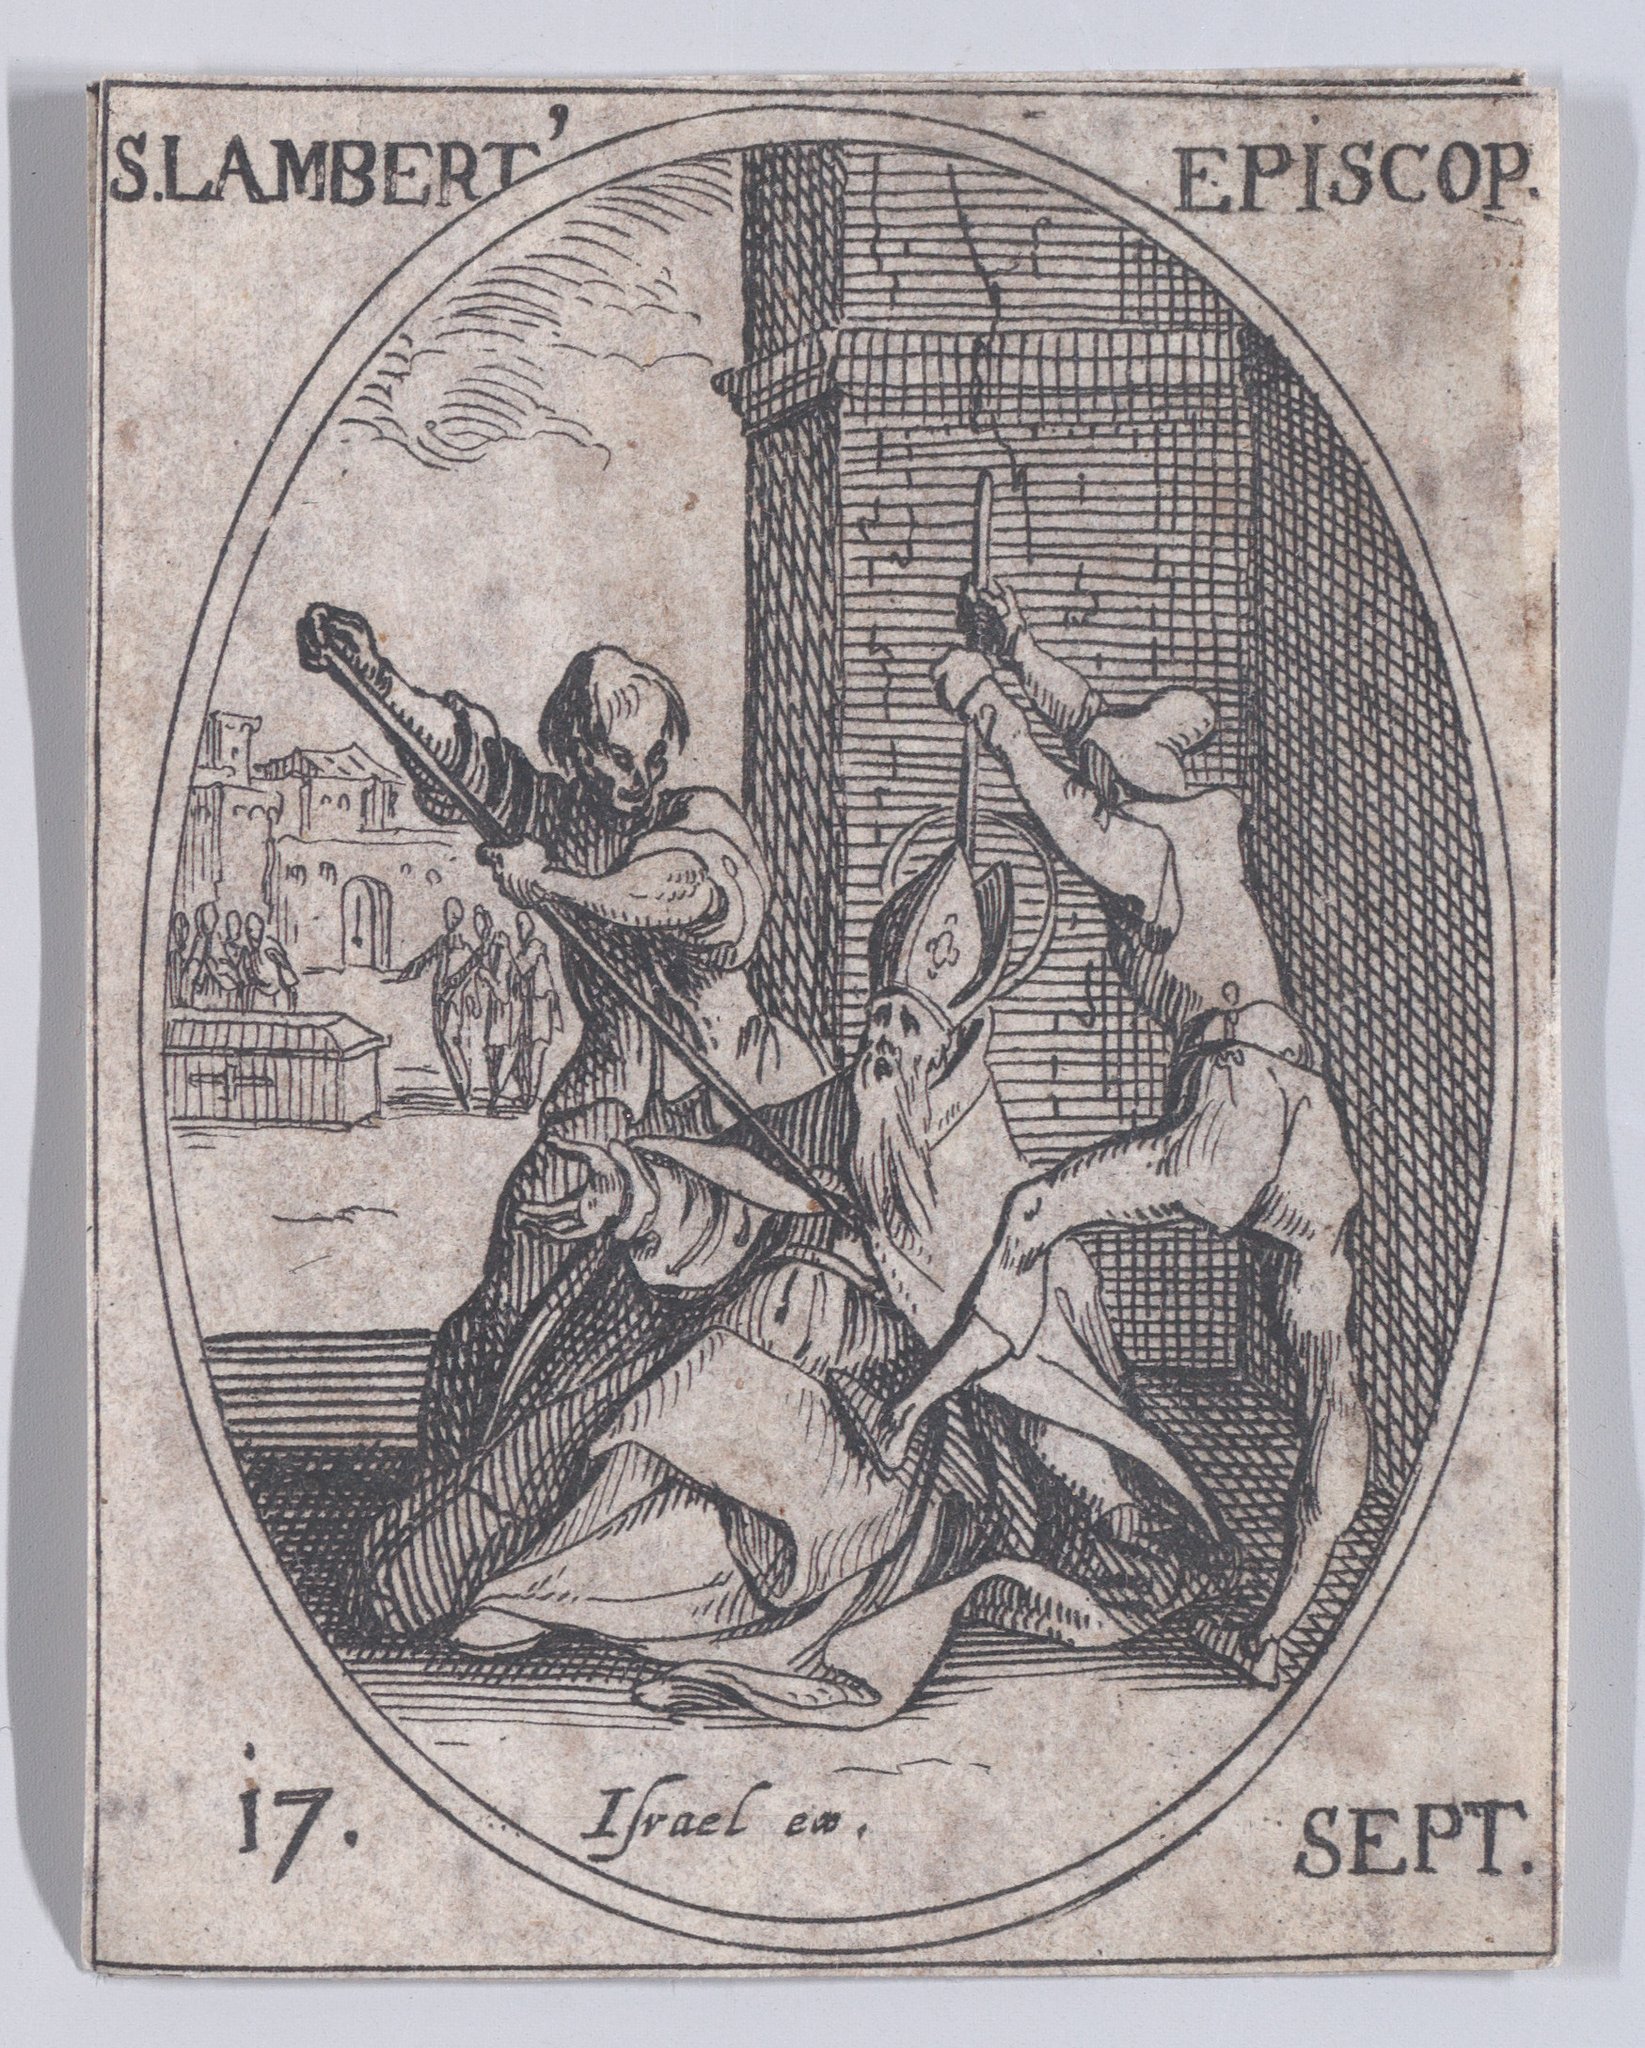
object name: print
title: S. Lambert, évêque (St. Lambert, Bishop), September 17th, from "Les Images De Tous Les Saincts et Saintes de L'Année" (Images of All of the Saints and Religious Events of the Year)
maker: jacques callot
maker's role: artist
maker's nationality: french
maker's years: 1592-1635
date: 1636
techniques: etching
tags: men,bishops,saints